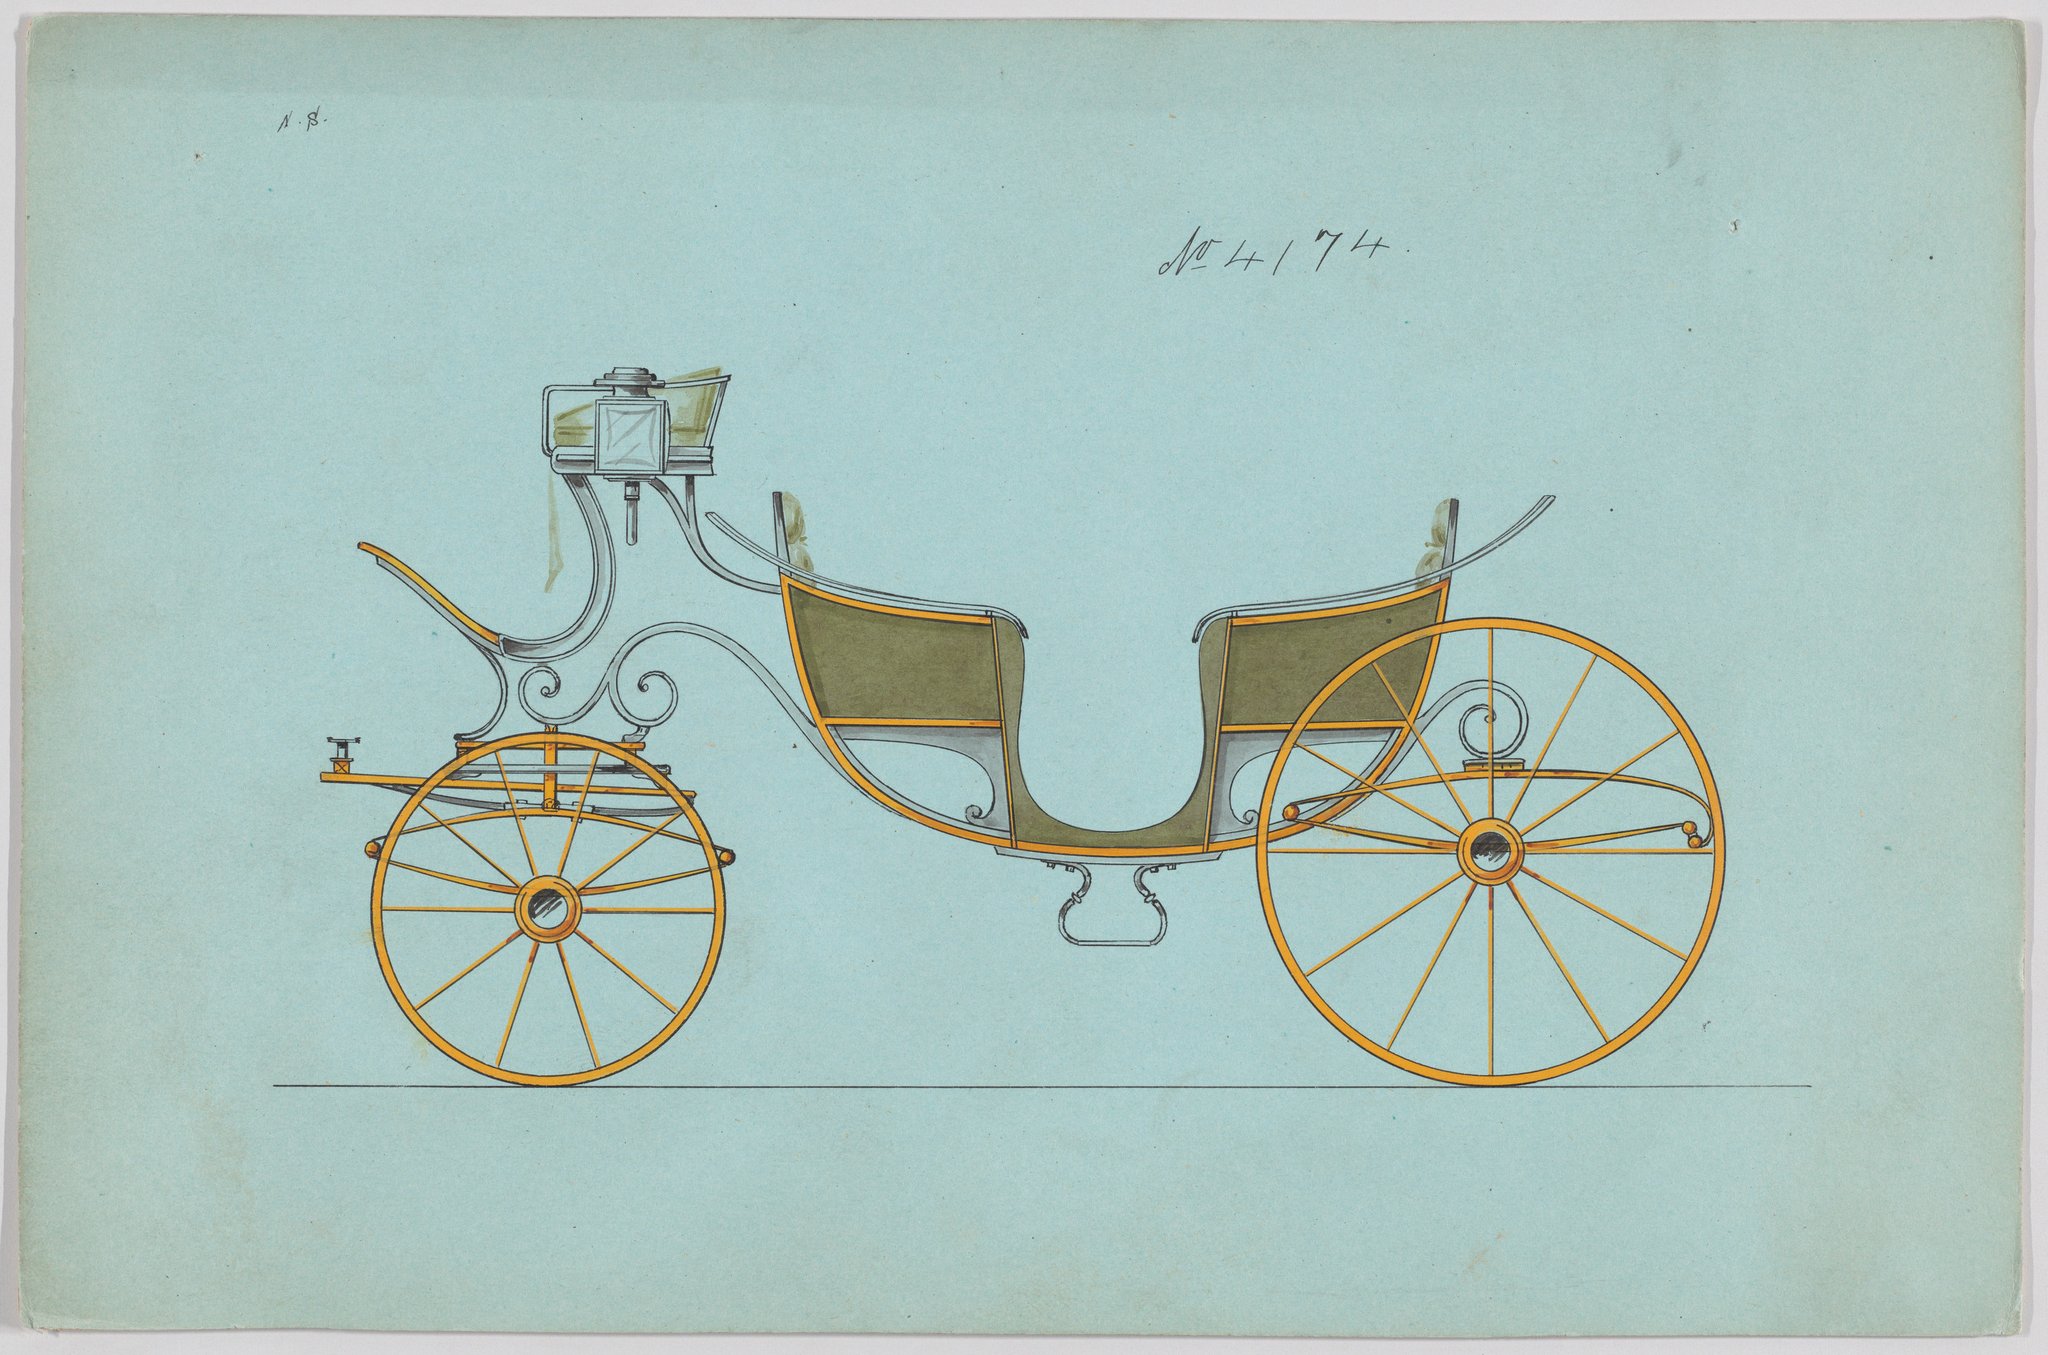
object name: drawing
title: Vis-a-Vis # 4174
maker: brewster & co.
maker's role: manufacturer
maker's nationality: american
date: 1892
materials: gouache, ink, watercolor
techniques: pen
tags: carriages